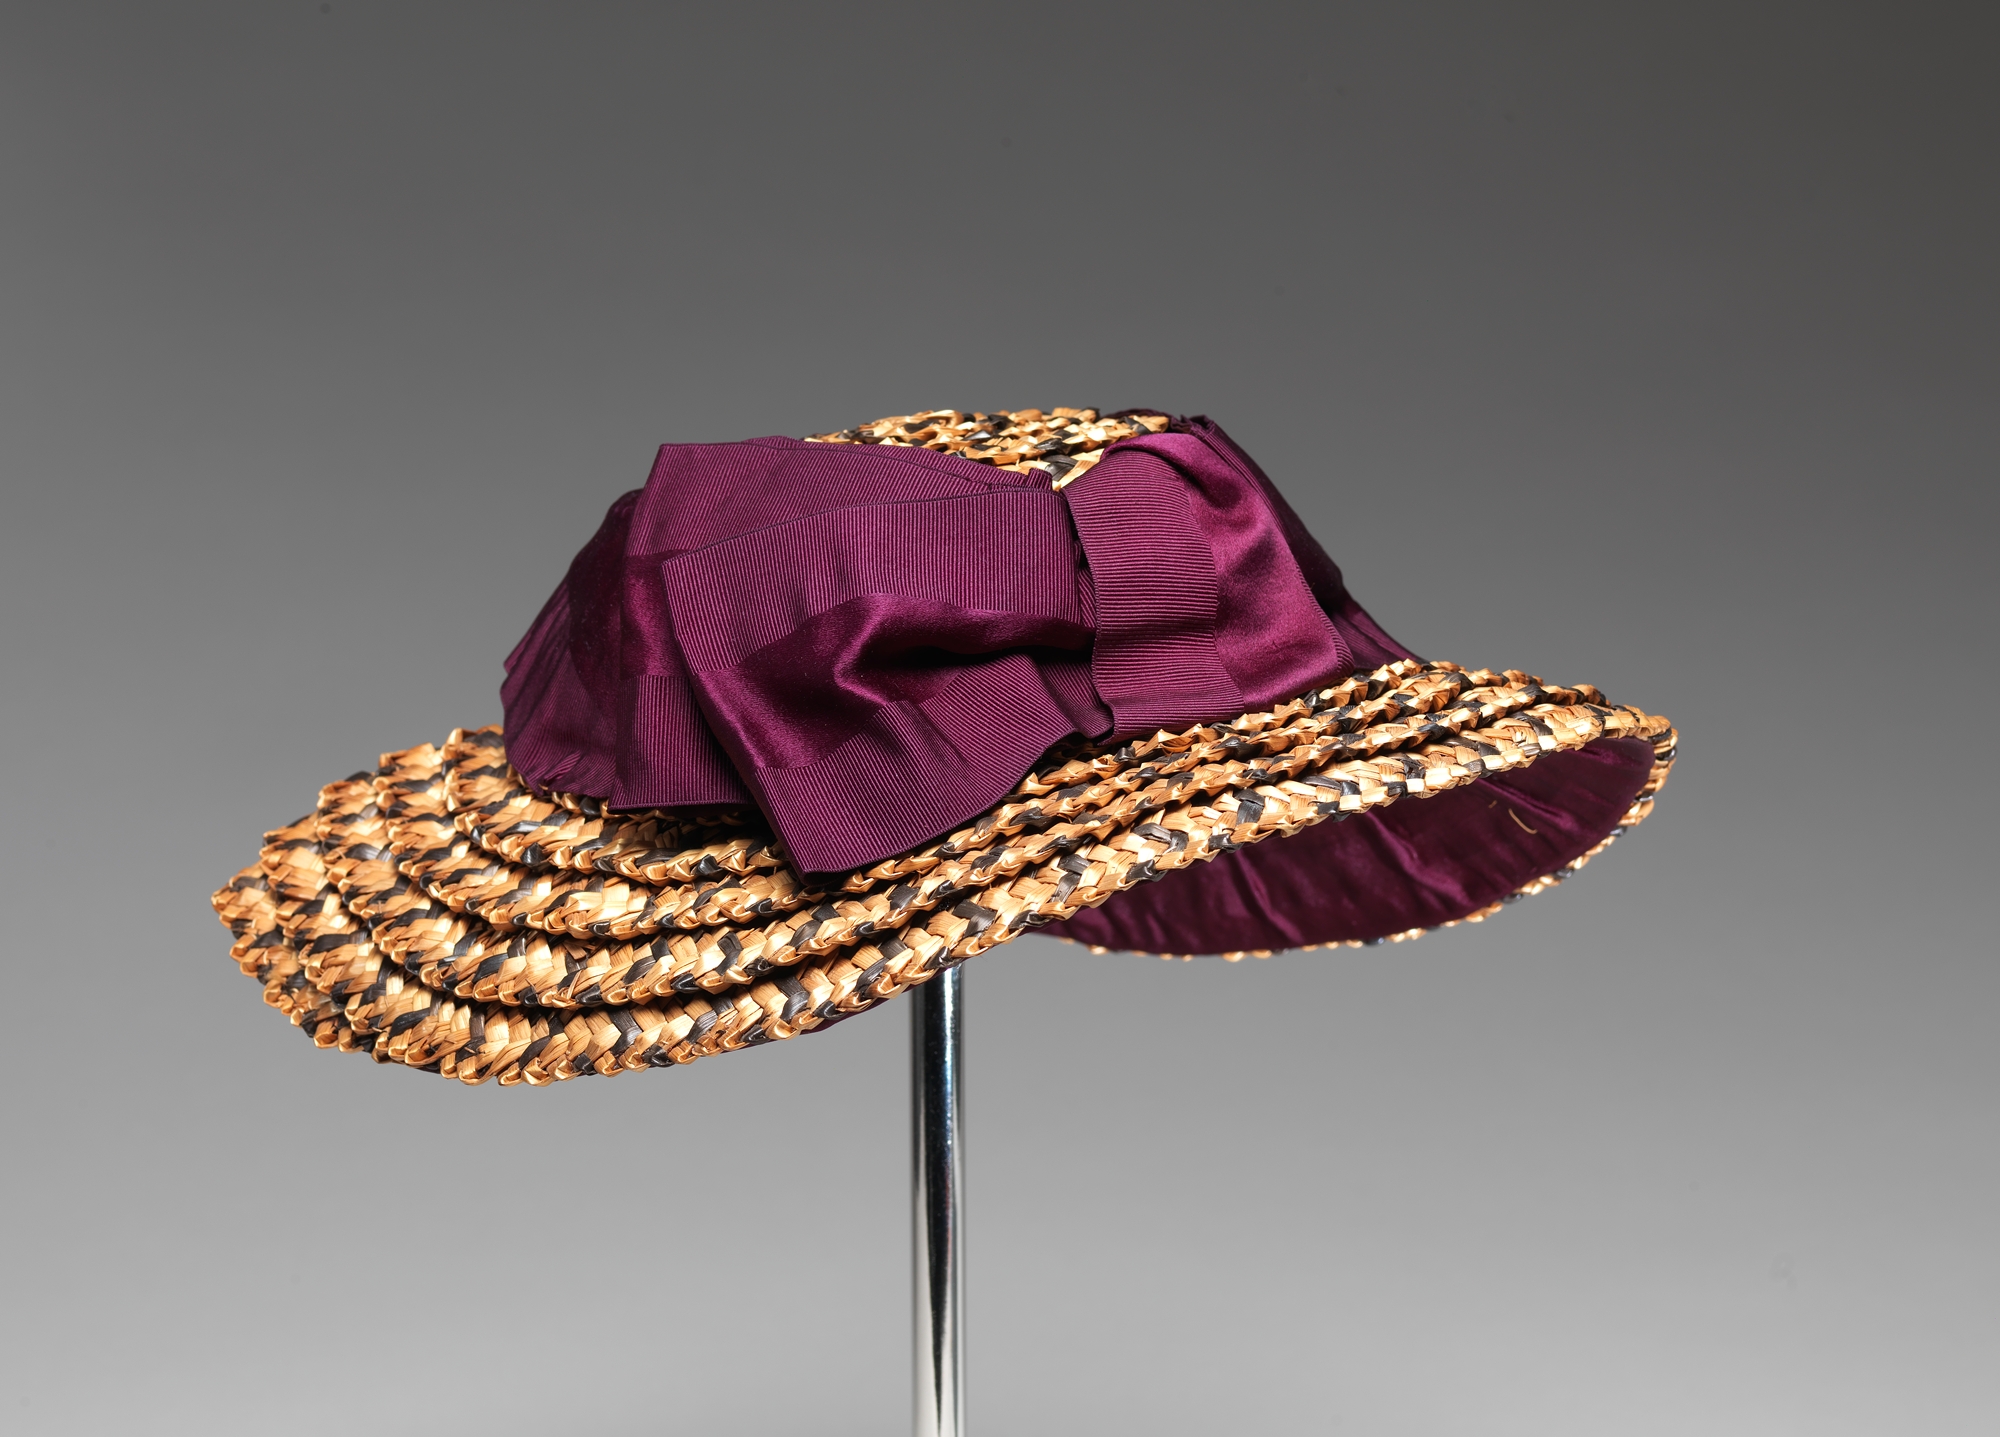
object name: hat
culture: american or european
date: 1887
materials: silk, fiber